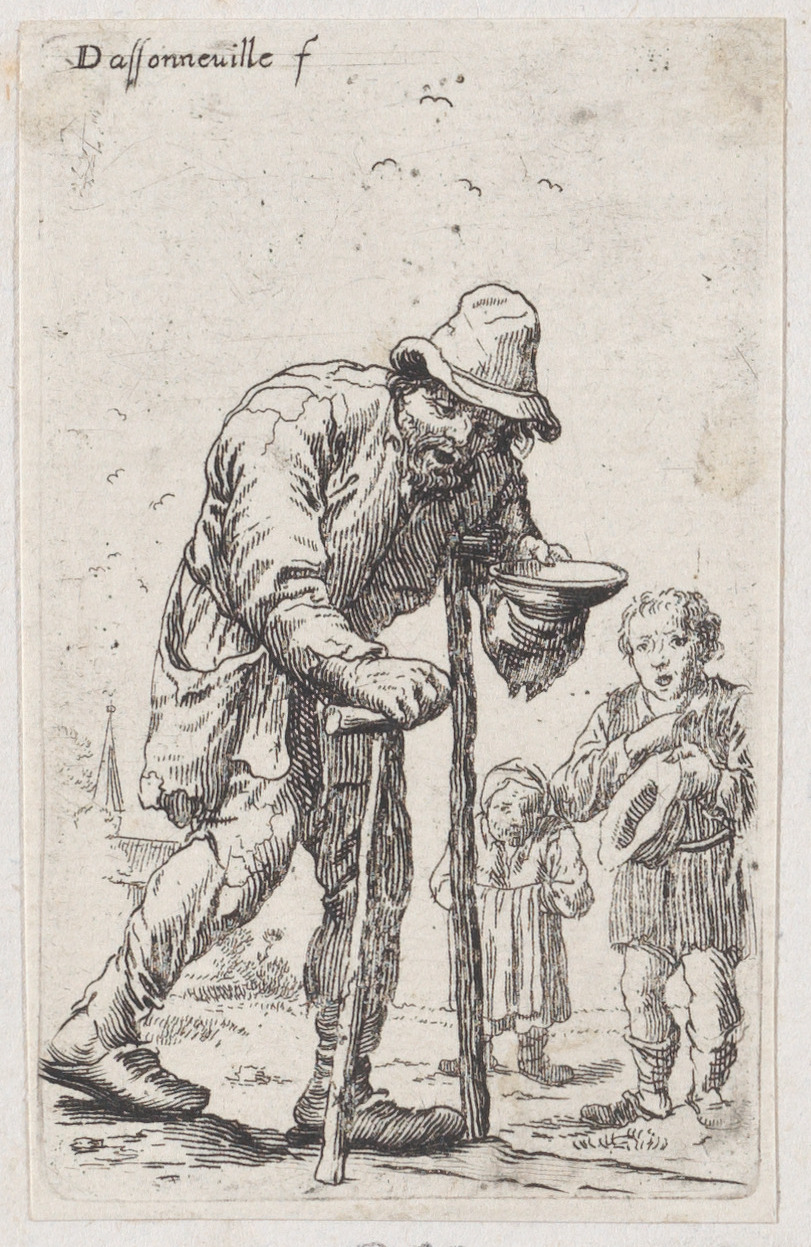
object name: print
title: Beggars asking for alms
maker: jacques dassonville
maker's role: artist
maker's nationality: french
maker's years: 1614-1675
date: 1640-1670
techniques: etching